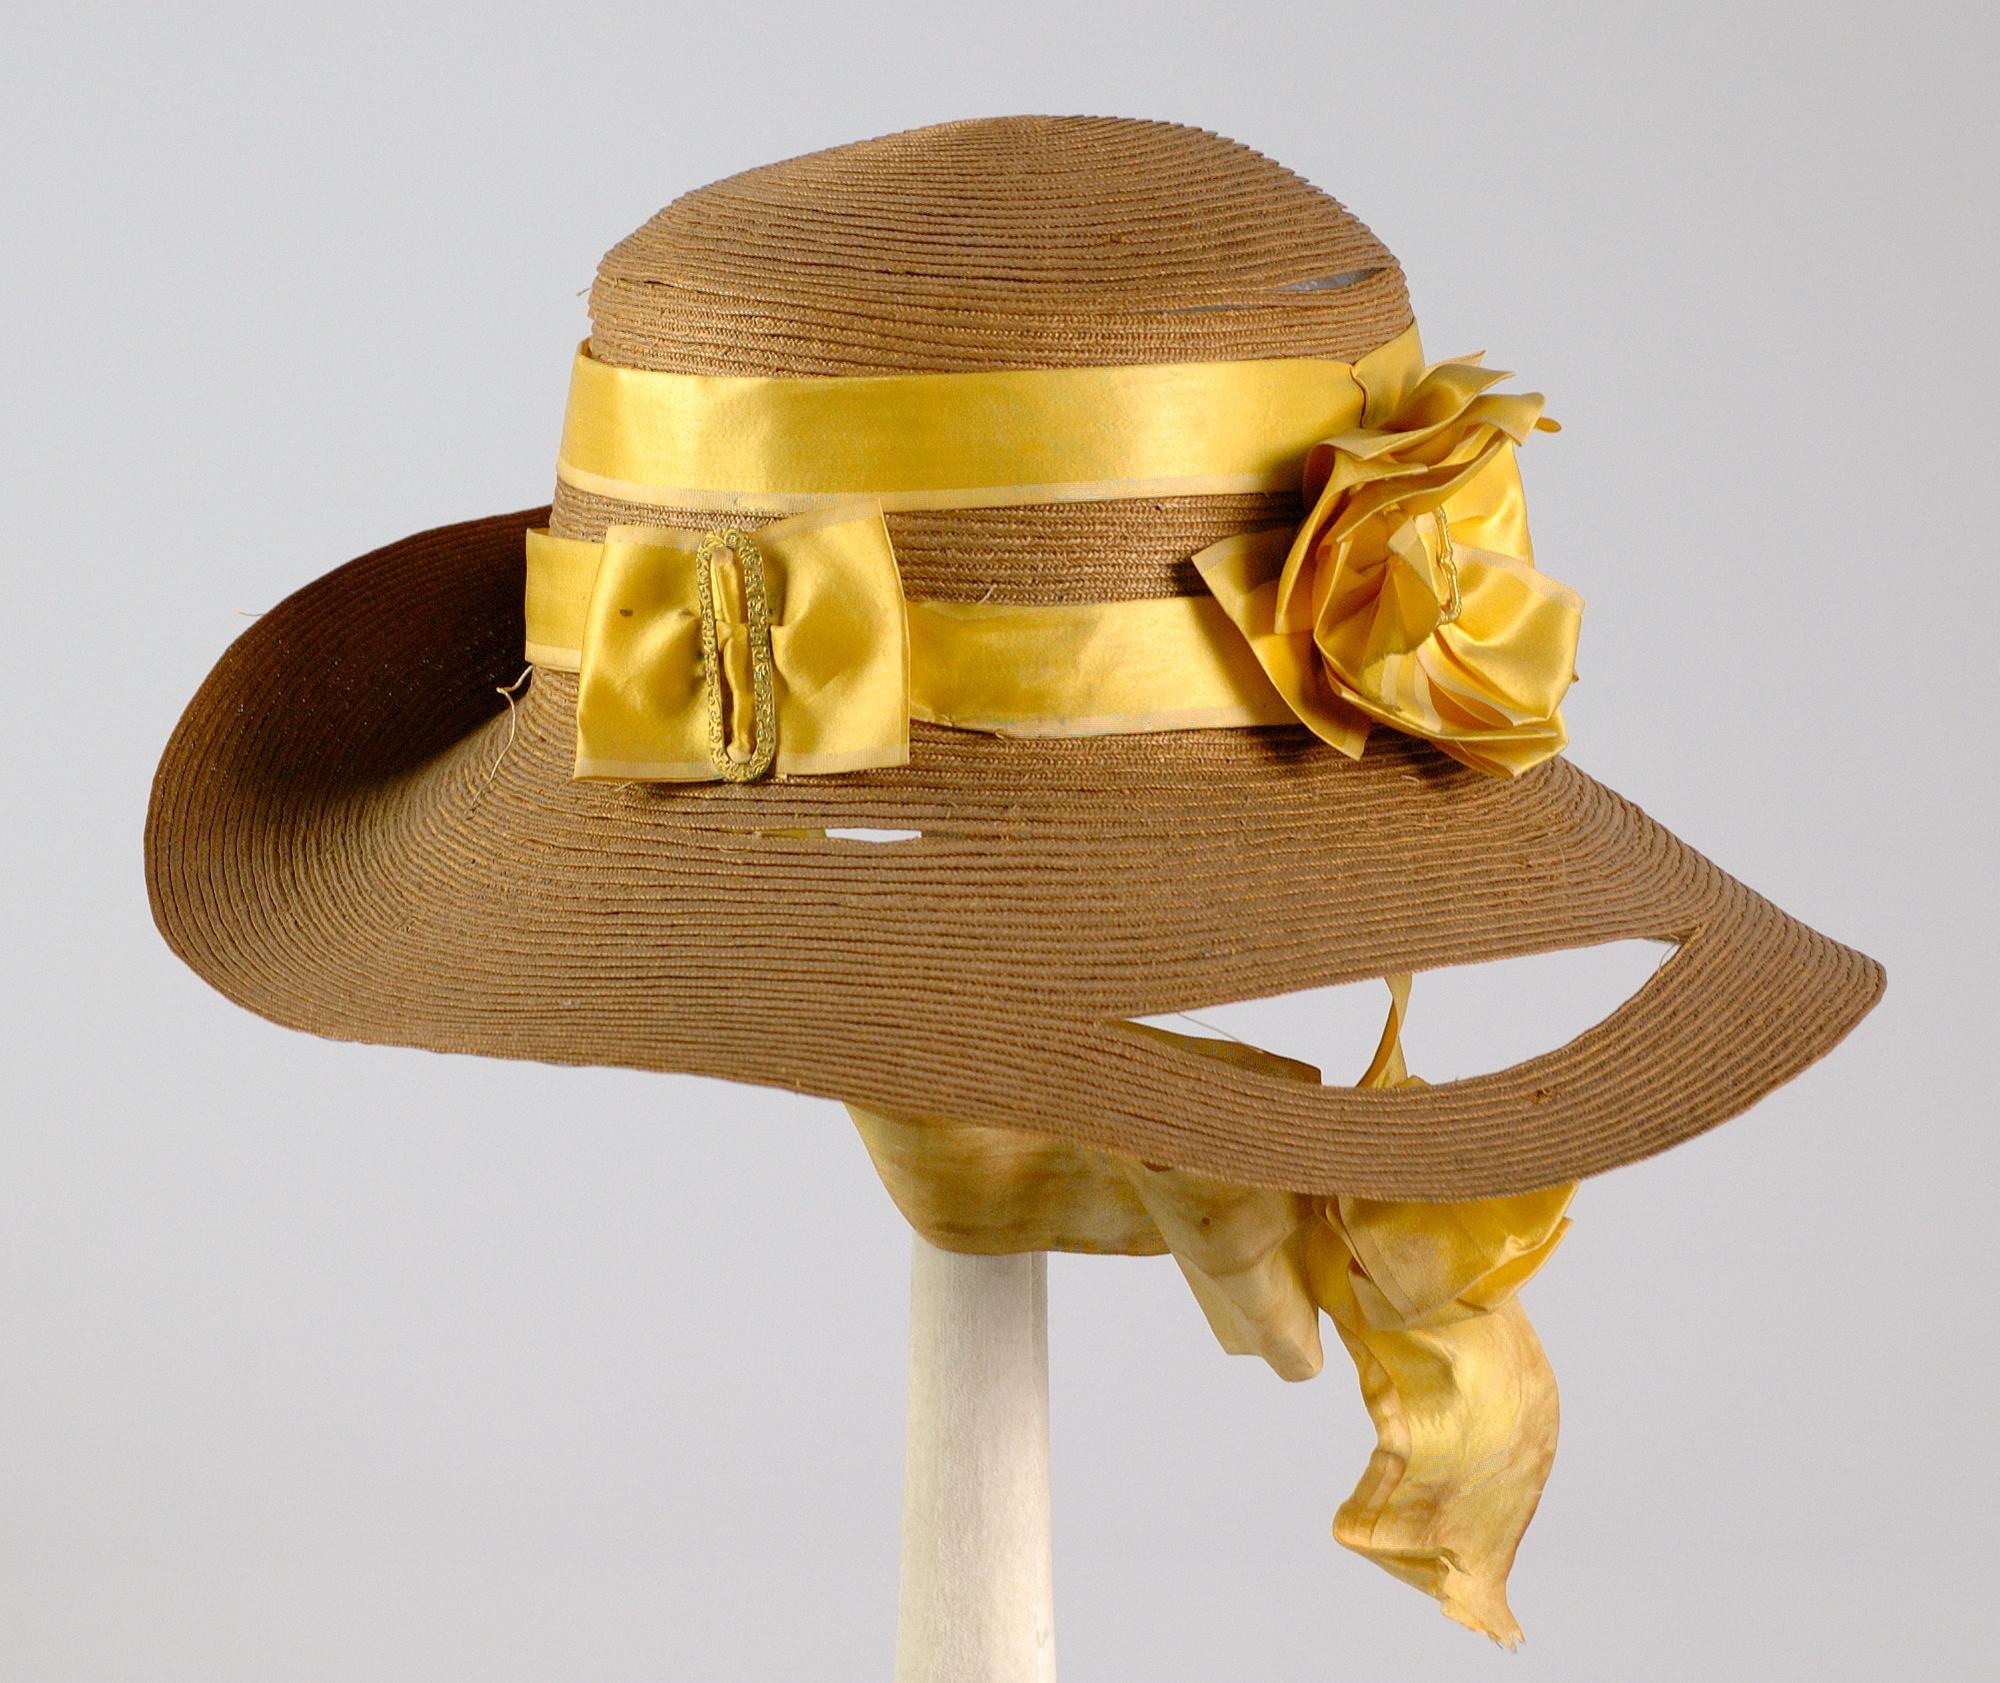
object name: hat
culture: american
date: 1855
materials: metal, silk, fiber